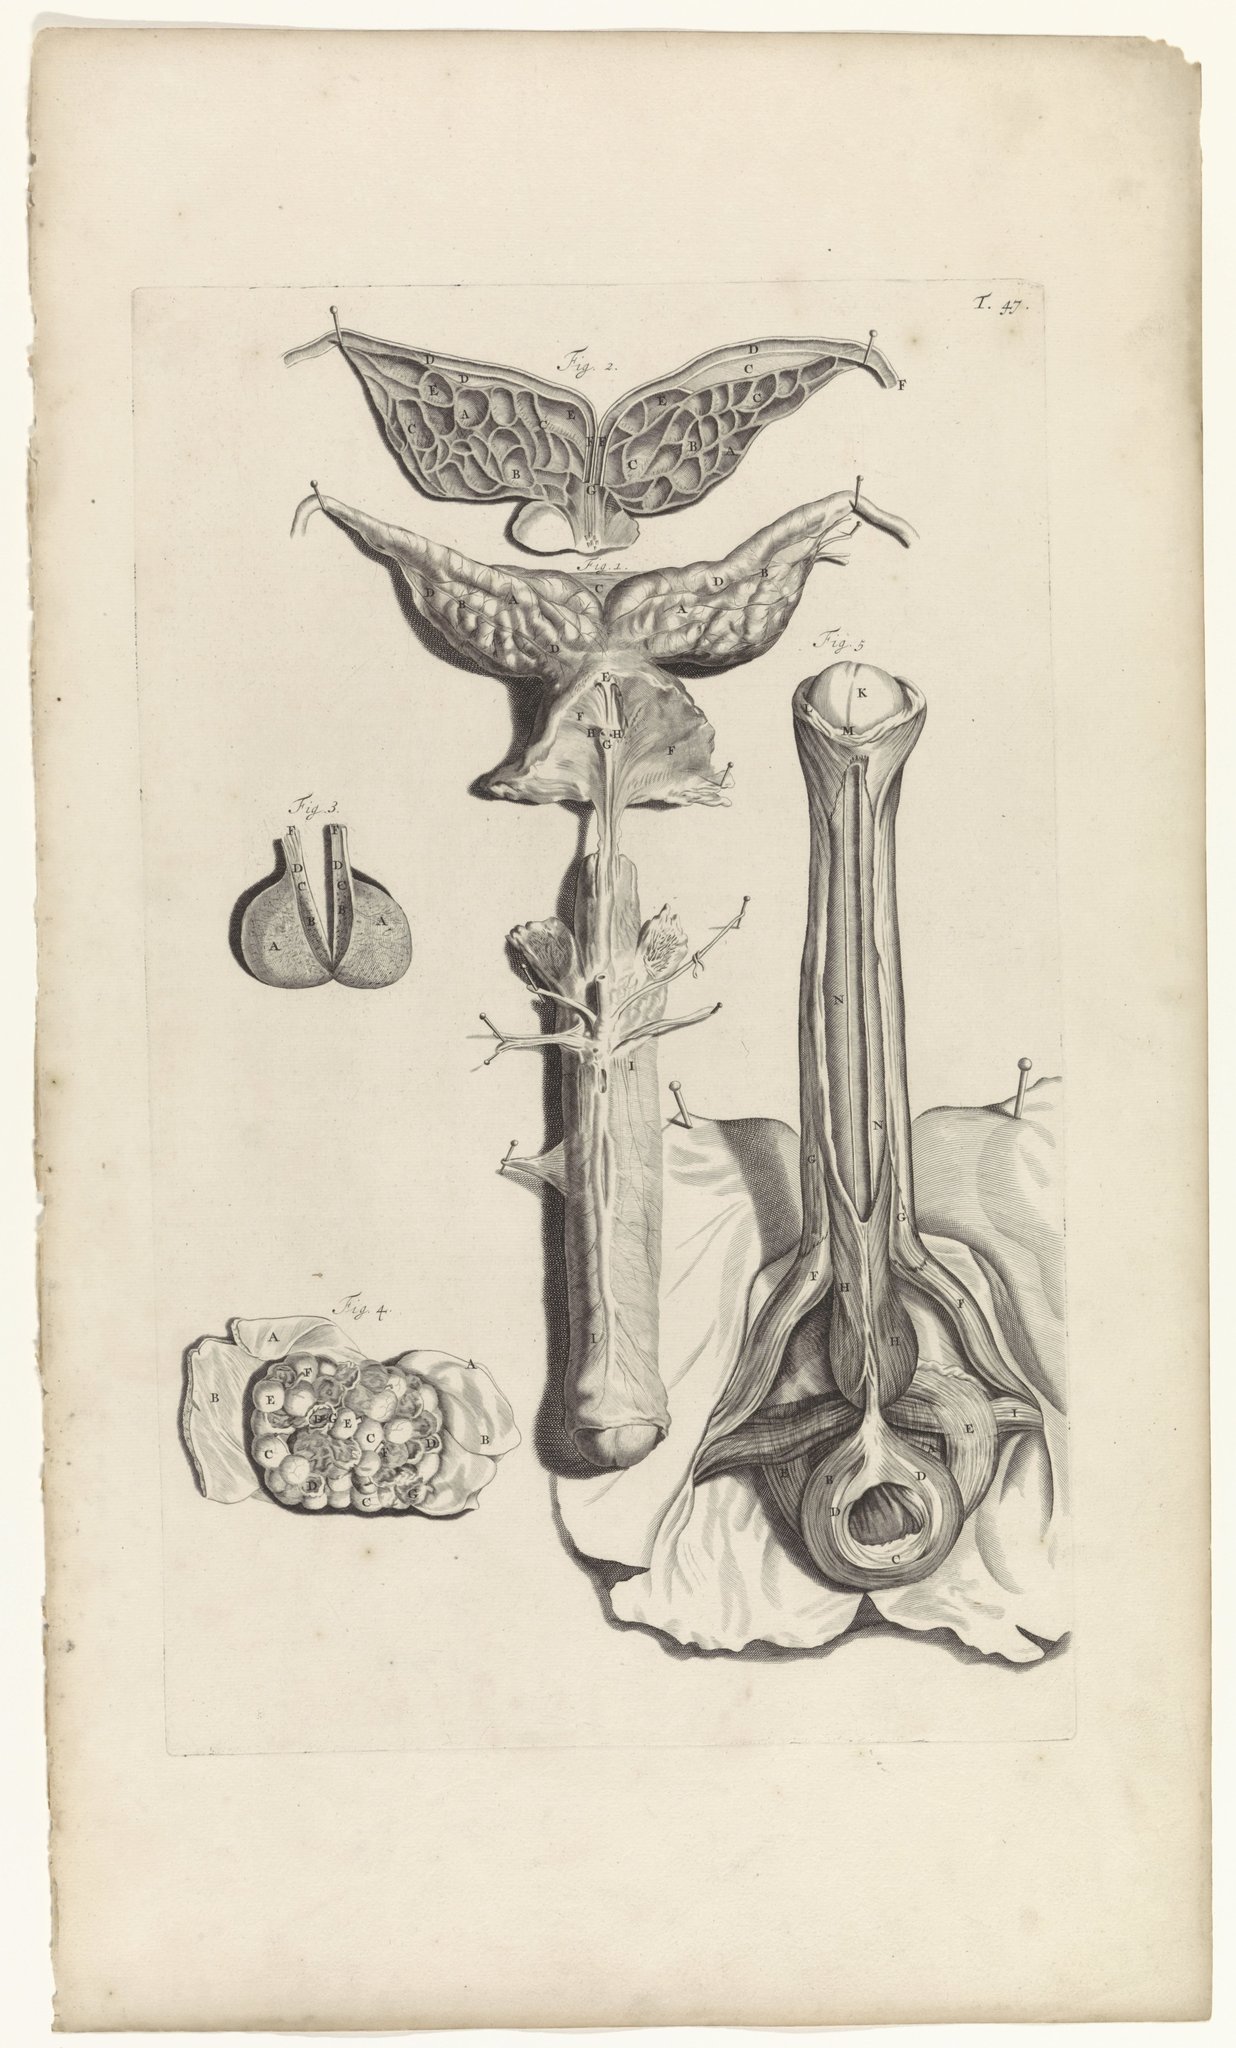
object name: print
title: Anatomische studie van de penis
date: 1685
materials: paper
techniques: engraving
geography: amsterdam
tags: male sexual organs, penis, phallus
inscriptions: collector's mark: Lugt 2228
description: Boekillustratie voor Bidloo, Godefridus. Anatomia humani corporis centum & quinque tabulis, per art. G. de Lairesse ad vivum delineatis, de monstrata, veterum recentiorumque inventis explicata plurimisque, hactenus non detectis, illustrata. Amsterdam: Weduwe Joannes van Someren, Hendrick Boom en erven Dirk Boom, 1685.